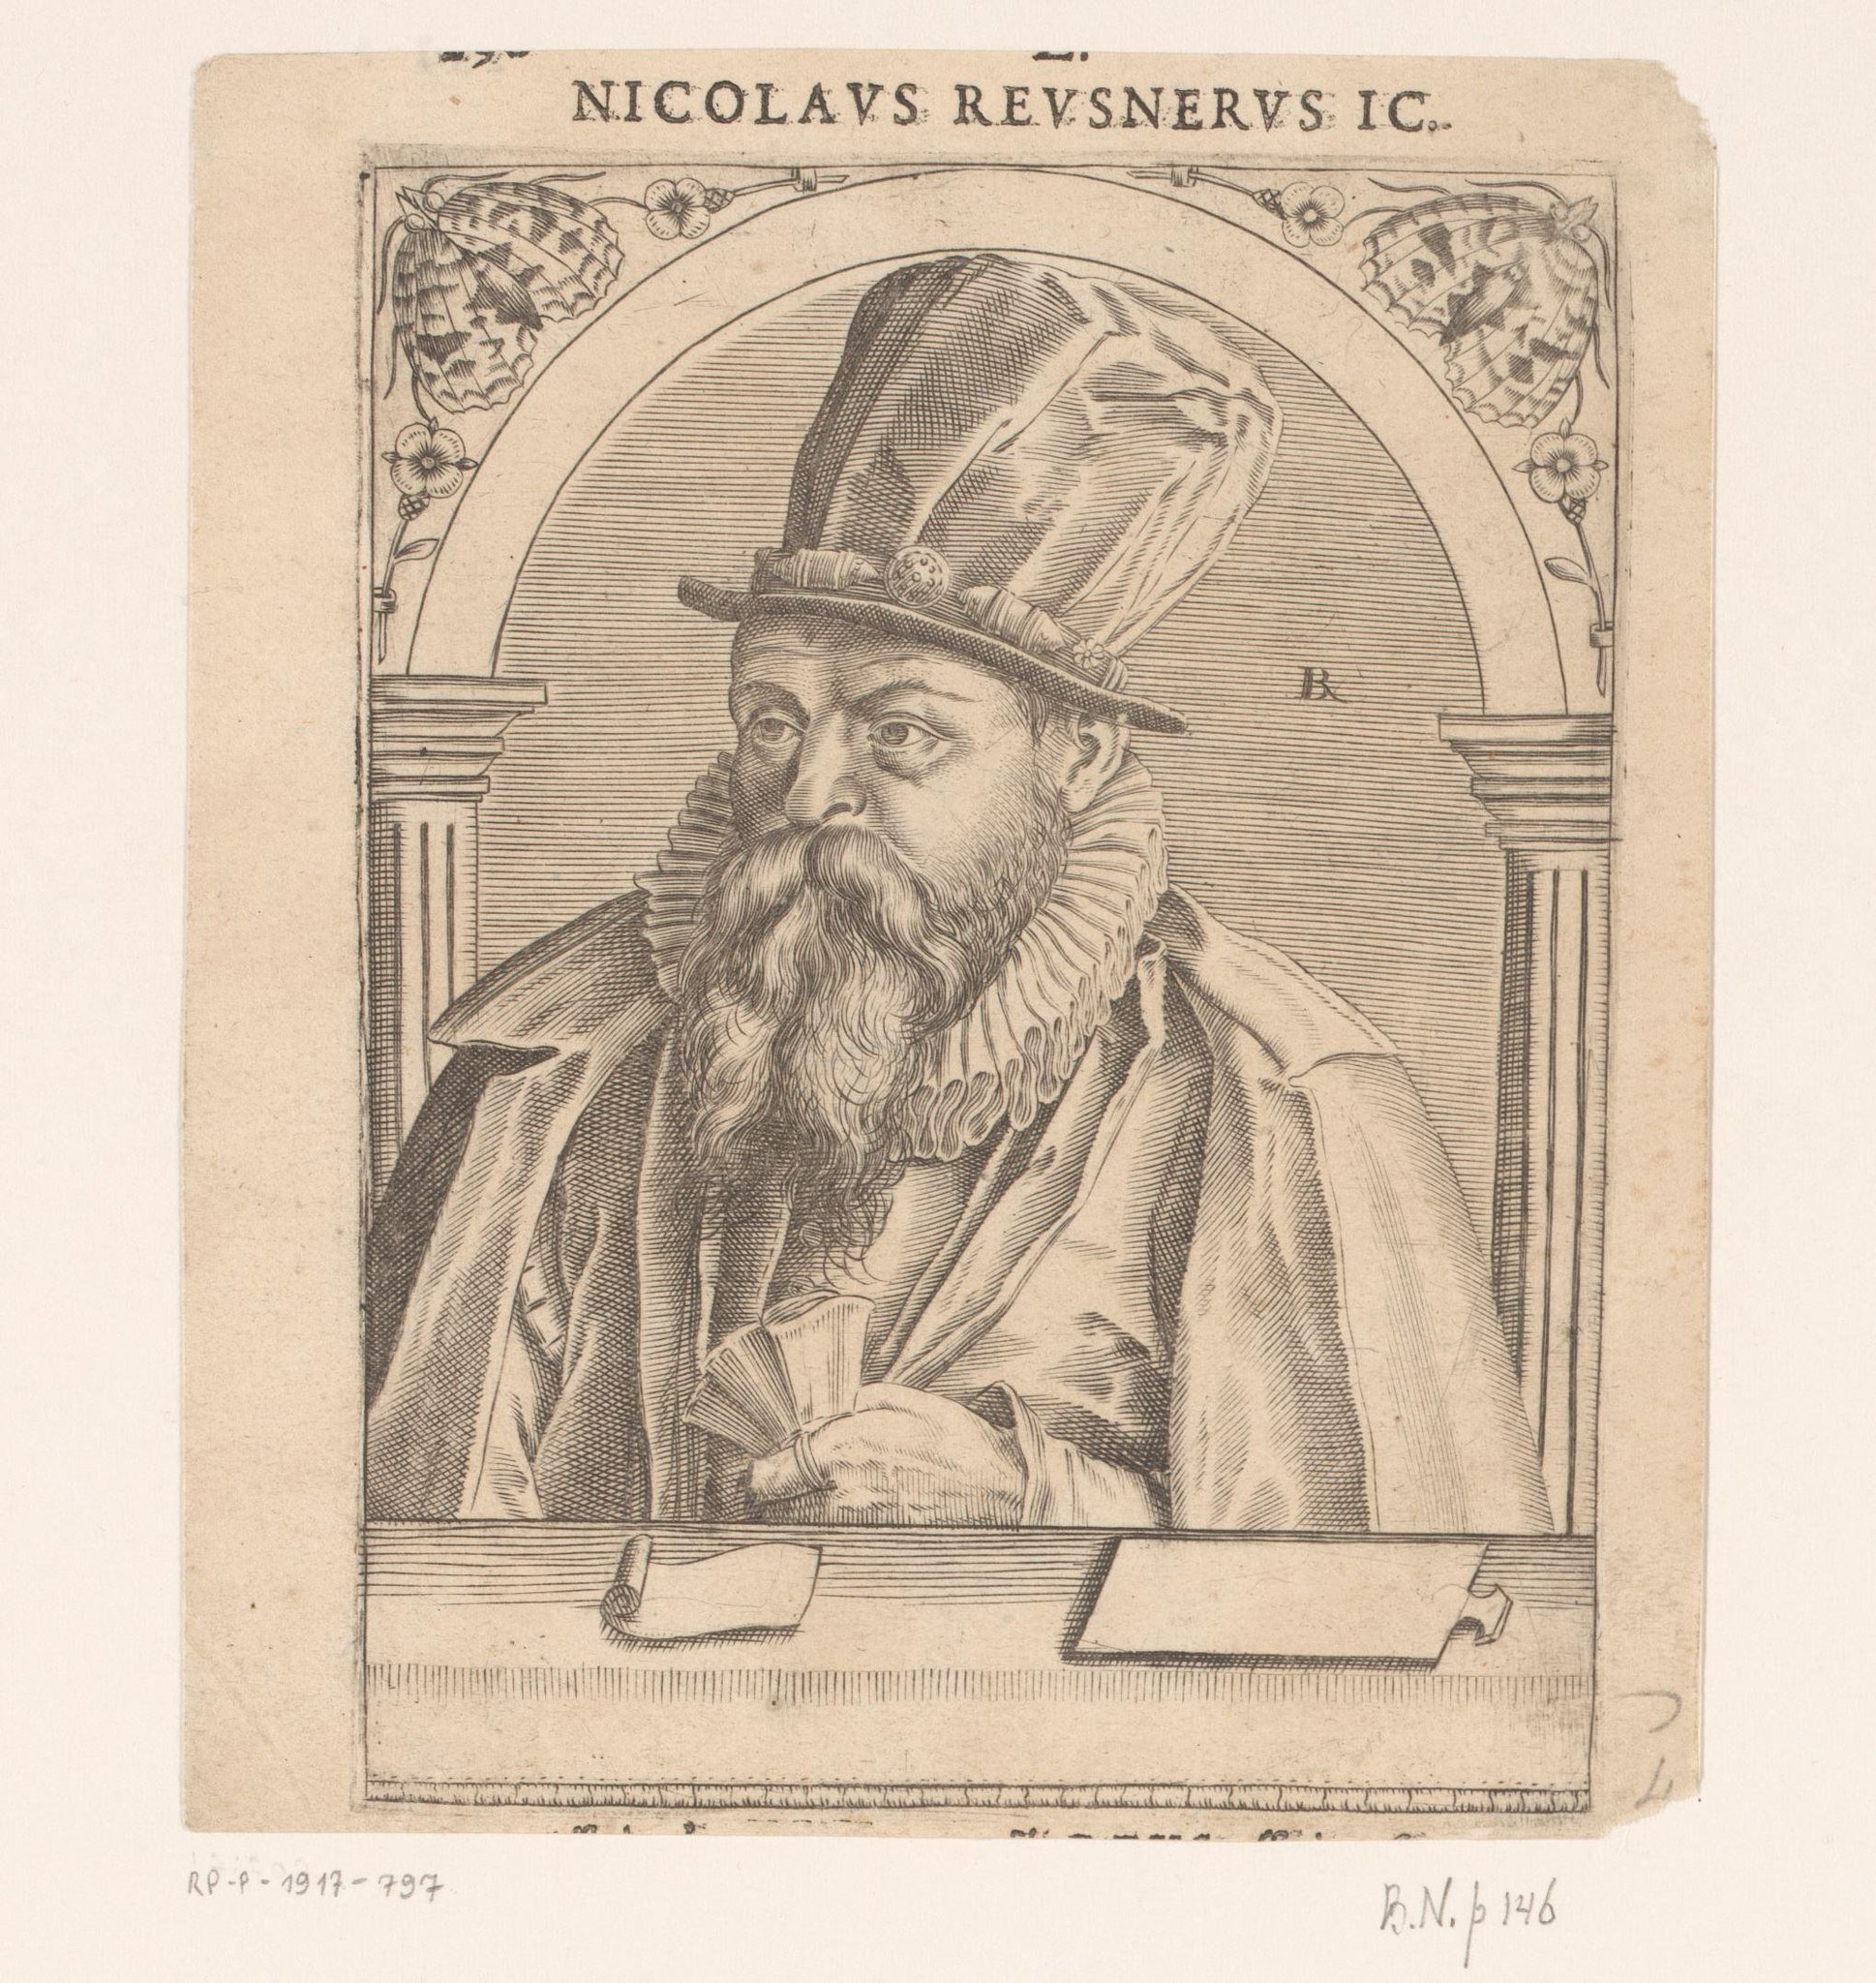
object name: print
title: Portret van Nicolaus Reusner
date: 1597-1599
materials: paper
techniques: engraving, letterpress printing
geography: france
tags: nikolaus reusner, gloves, mittens, etc., insects: moth - ff - fabulous animals (sometimes wrongly called 'grotesques'); 'mostri' (ripa), historical persons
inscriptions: collector's mark: Lugt 2228